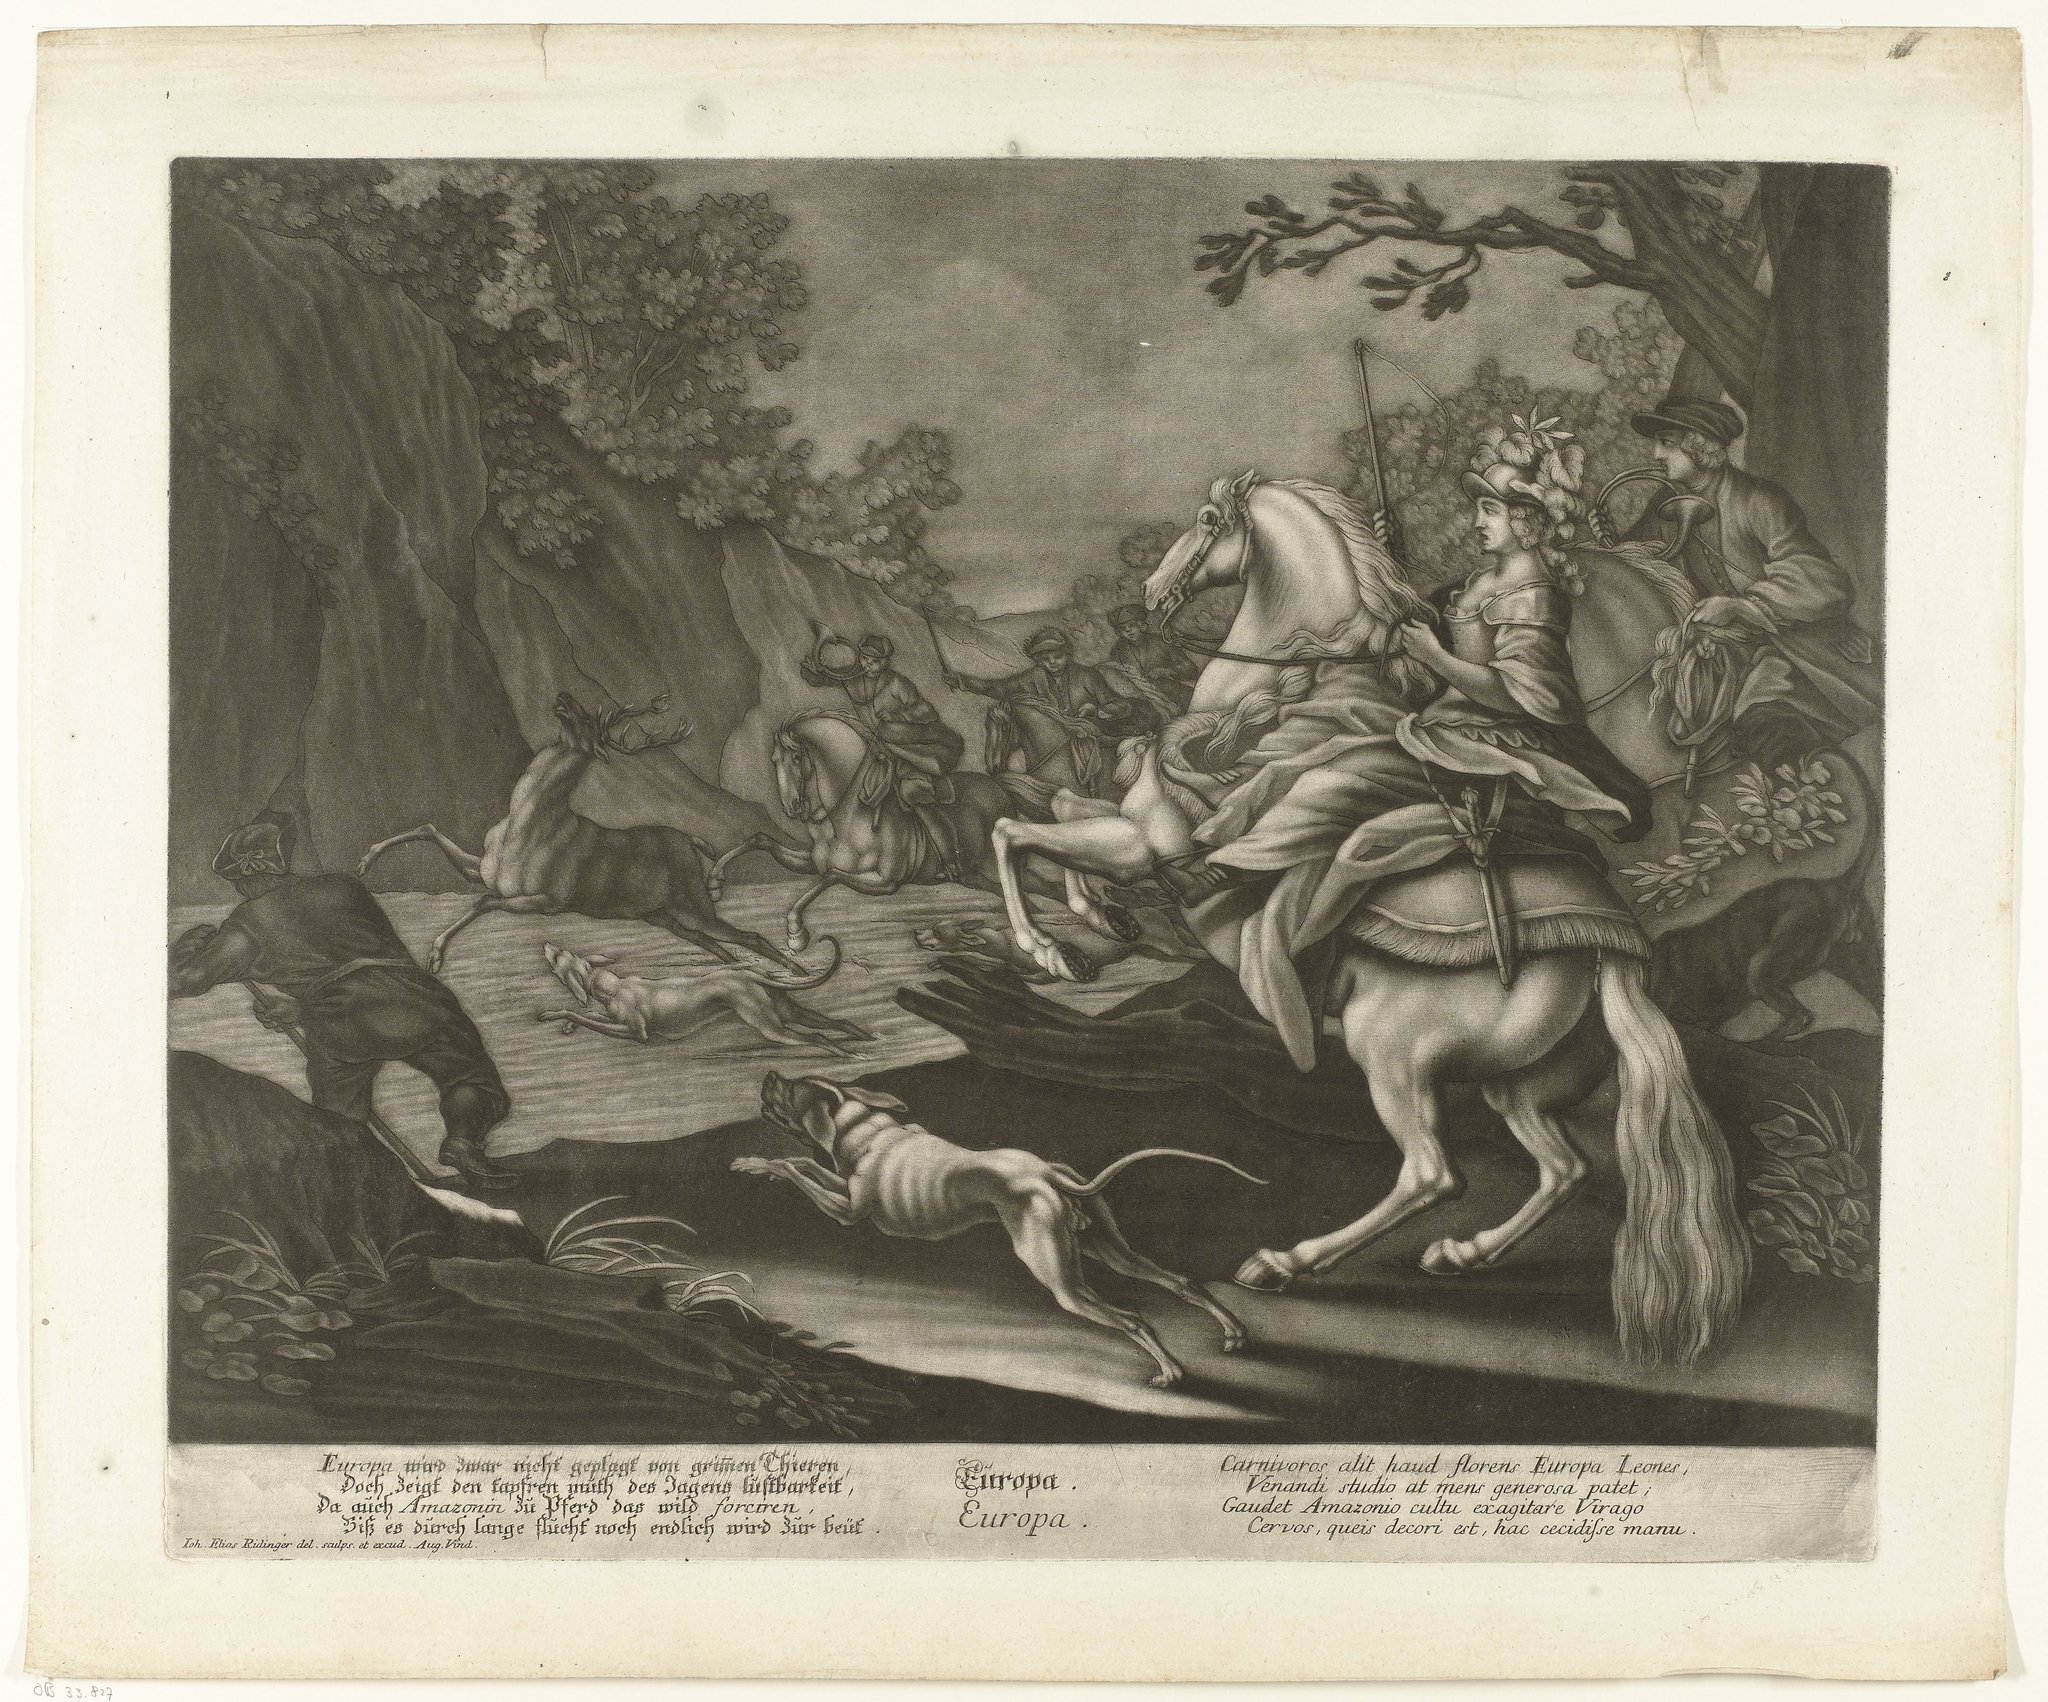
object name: print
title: Europa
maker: johann elias ridinger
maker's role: draughtsman, painter, print maker, publisher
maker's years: 1698-1767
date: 1708-1767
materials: paper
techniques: etching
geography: augsburg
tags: stag-hunting, europe represented allegorically; 'europa' (ripa)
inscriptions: collector's mark: Lugt 240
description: Europa gesymboliseerd als een hertenjacht.